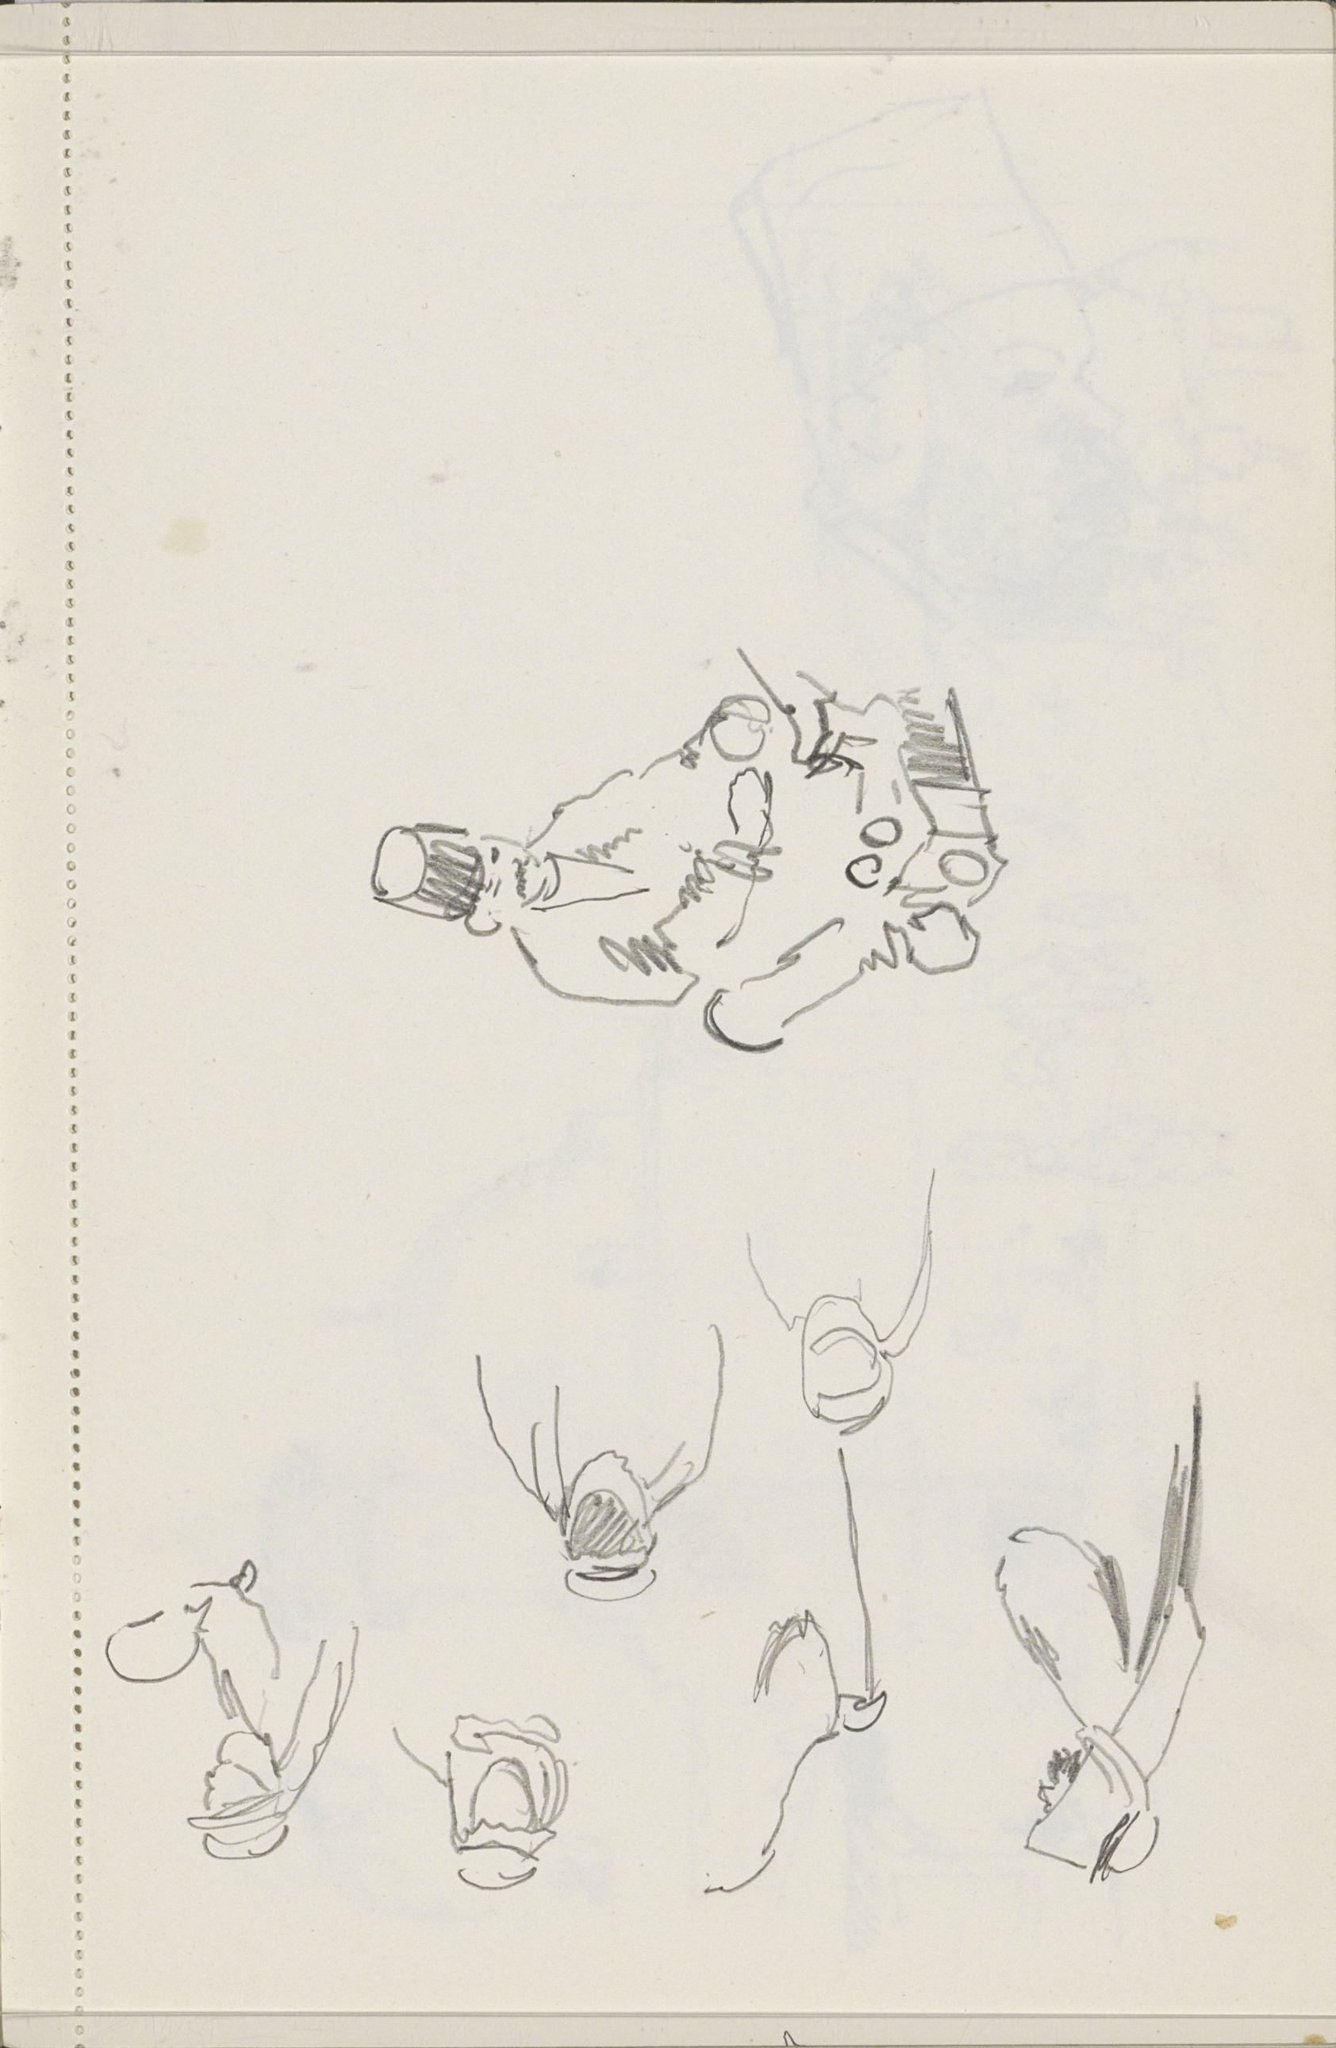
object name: sketchbook leaf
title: Figuren met oosterse hoofddeksels en een schoenenpoetser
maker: cornelis vreedenburgh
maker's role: draughtsman, print maker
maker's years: 1880-1946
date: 1936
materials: paper, pencil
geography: maghreb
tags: folk costume, regional costume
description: Blad 45 recto uit een schetsboek met 73 bladen.